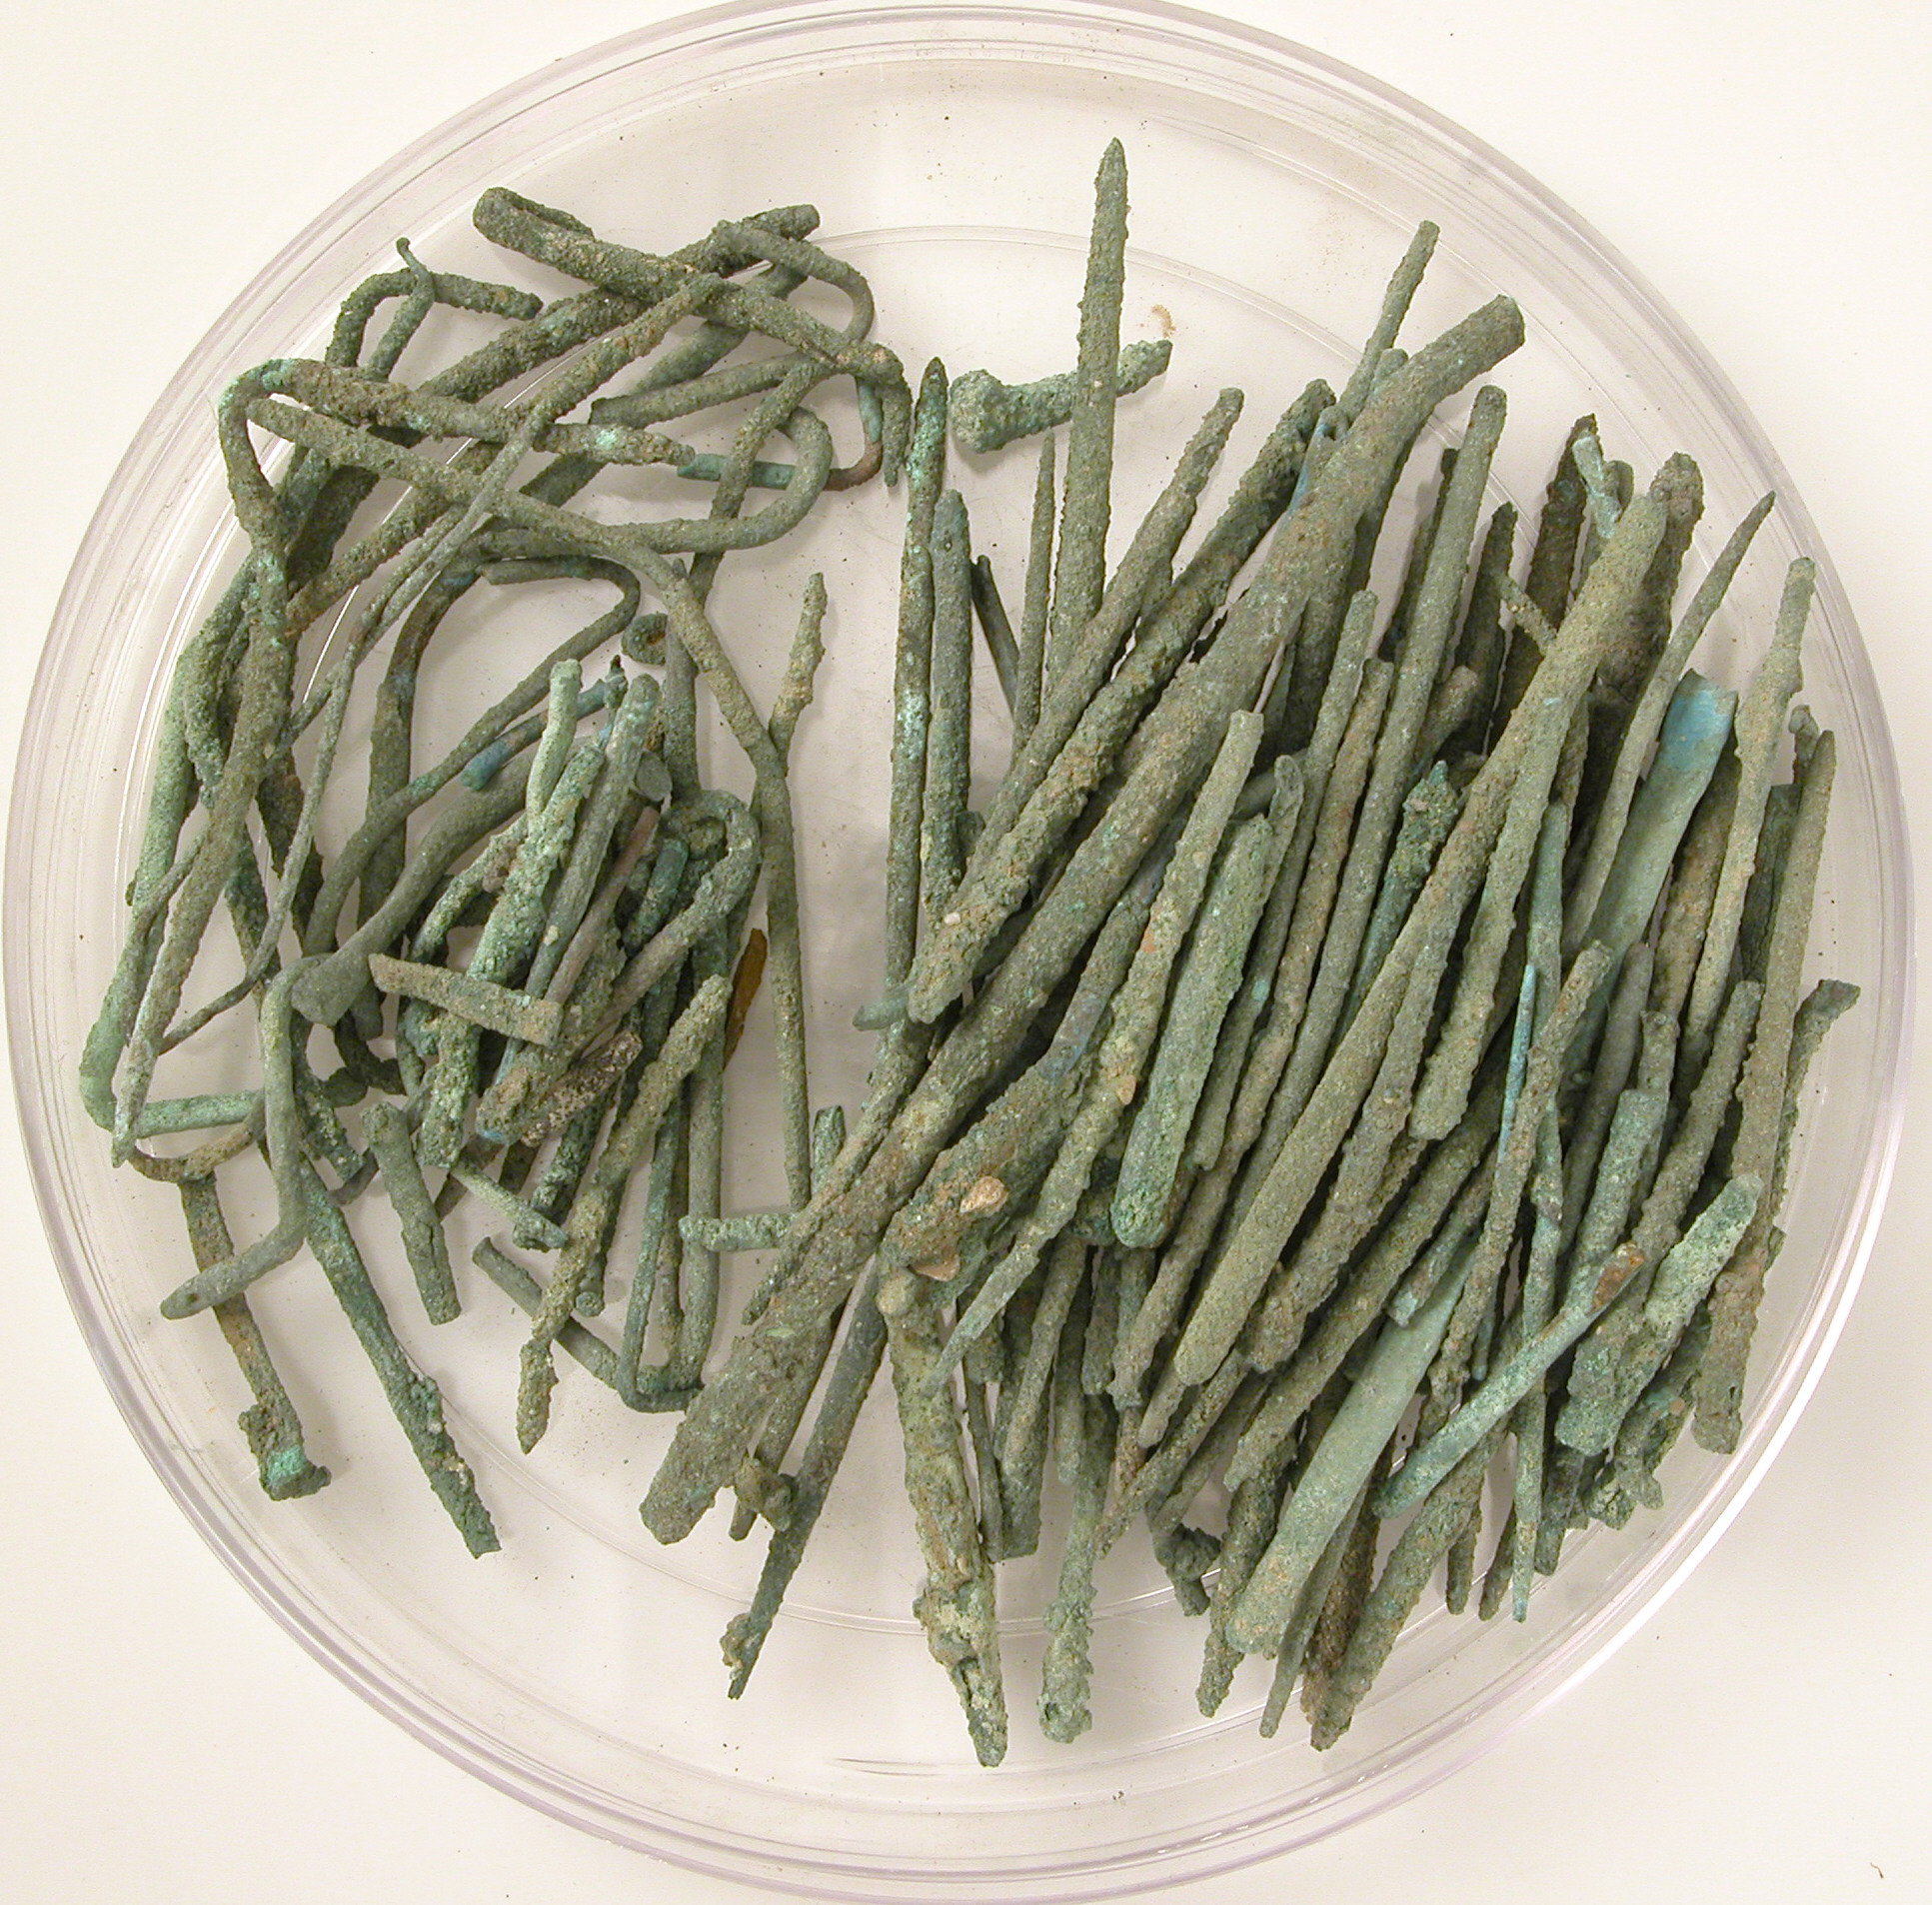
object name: fragment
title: Pin, Wire and Nail Fragments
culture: coptic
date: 301-700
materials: copper alloy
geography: egypt